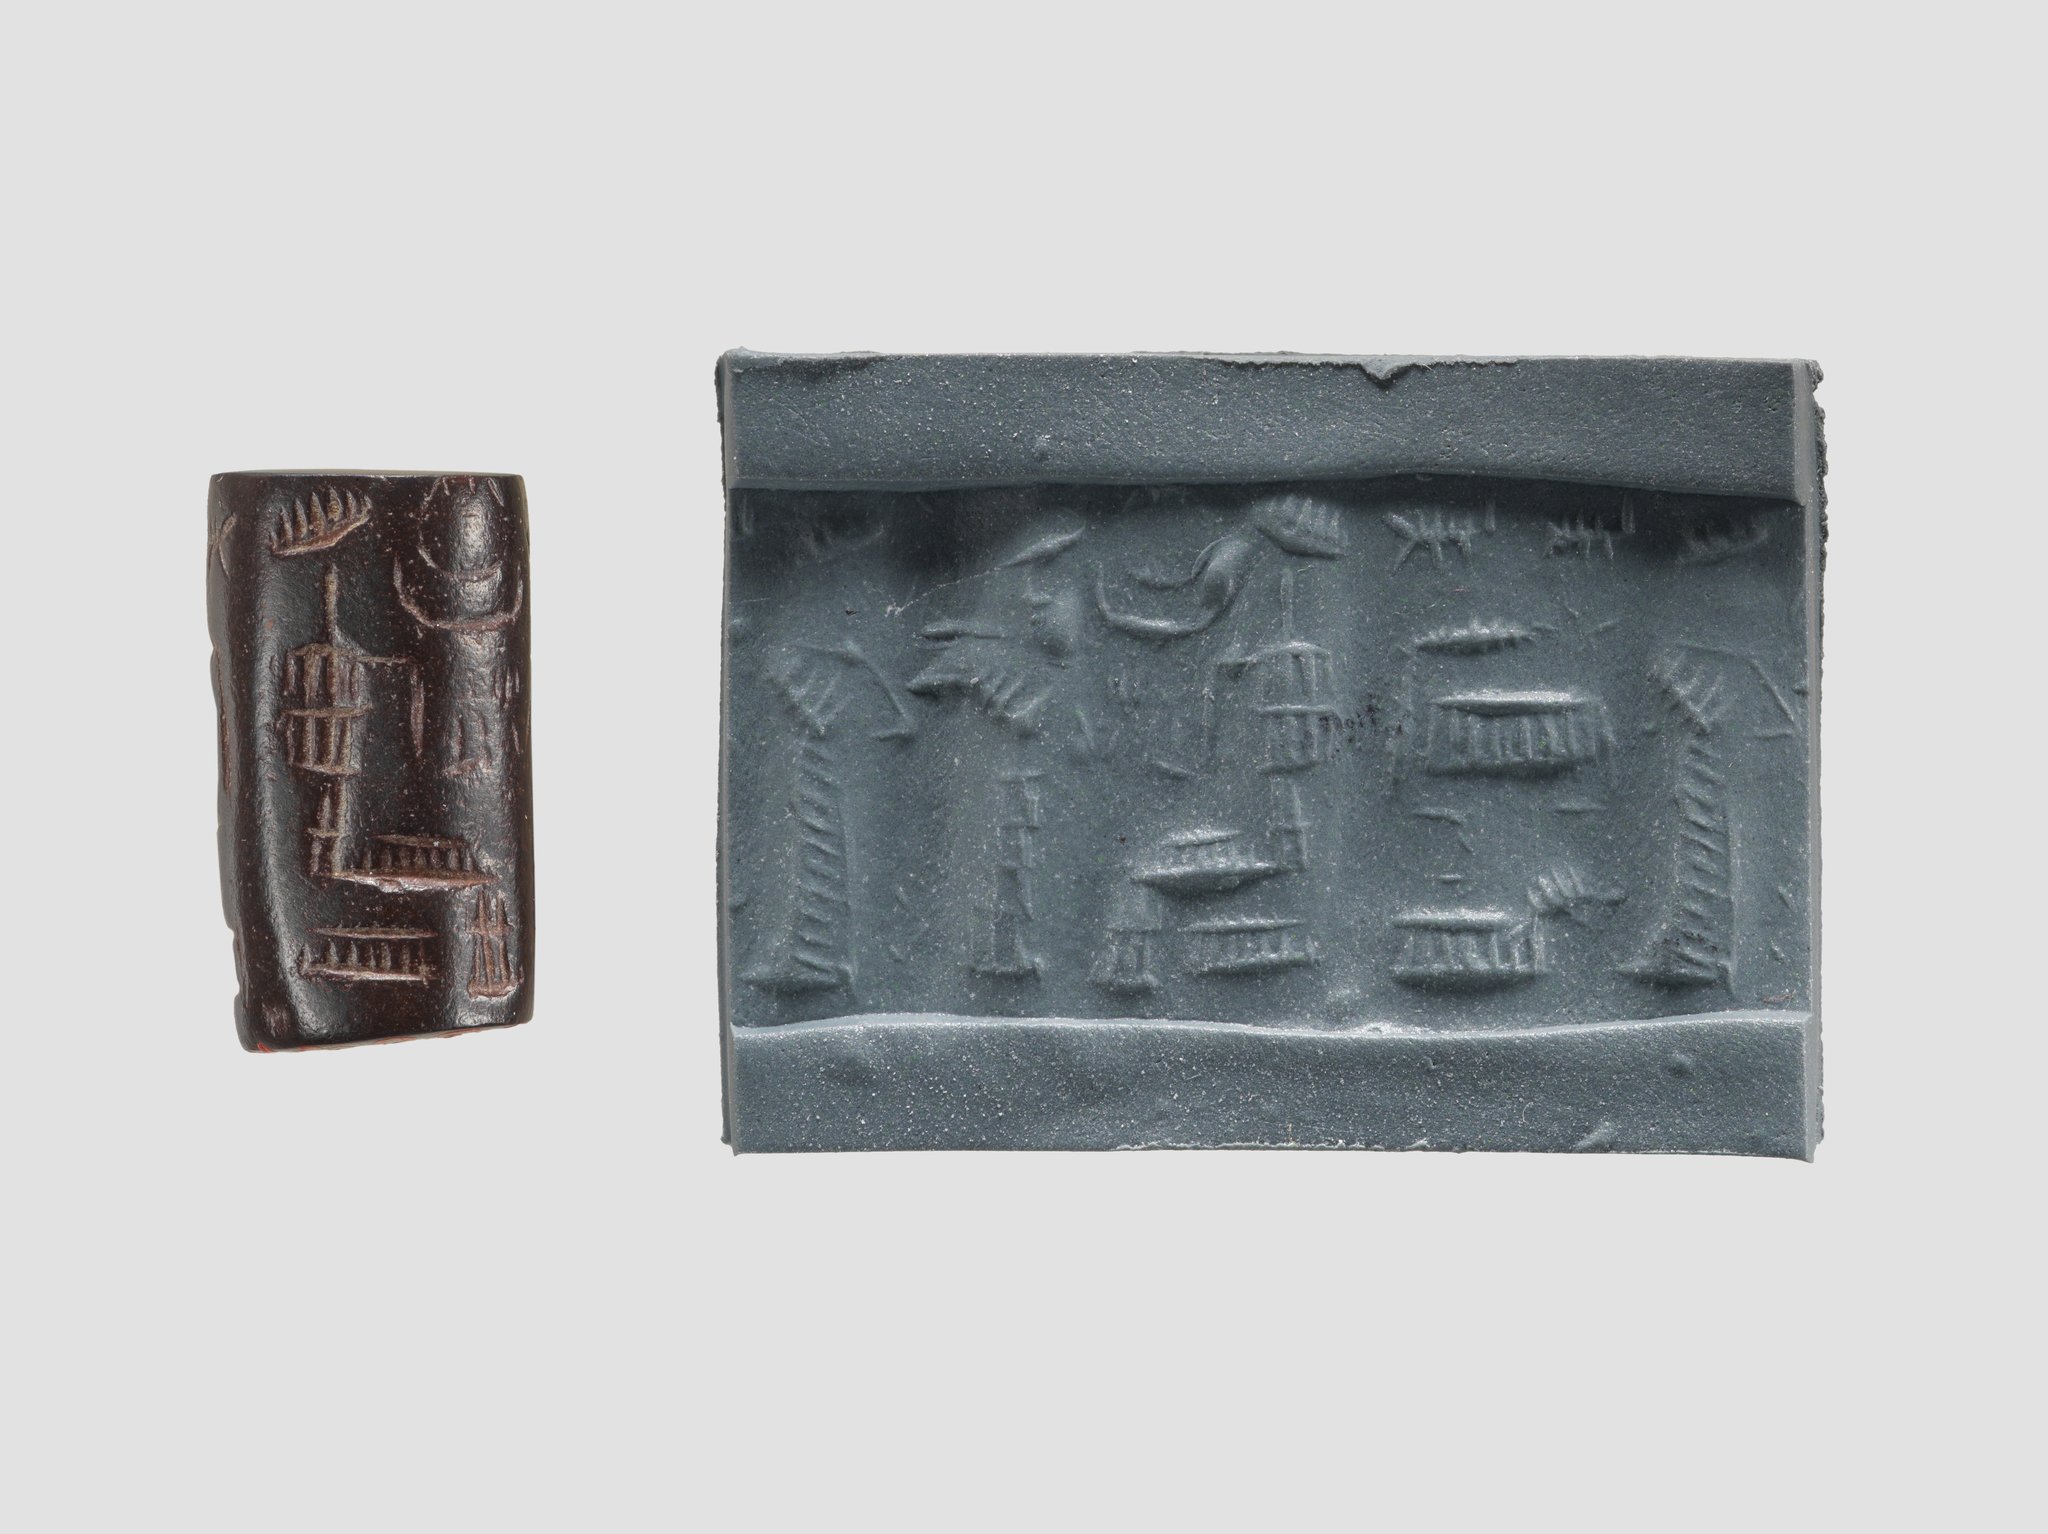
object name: cylinder seal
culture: assyrian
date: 2000-1668 BCE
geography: anatolia